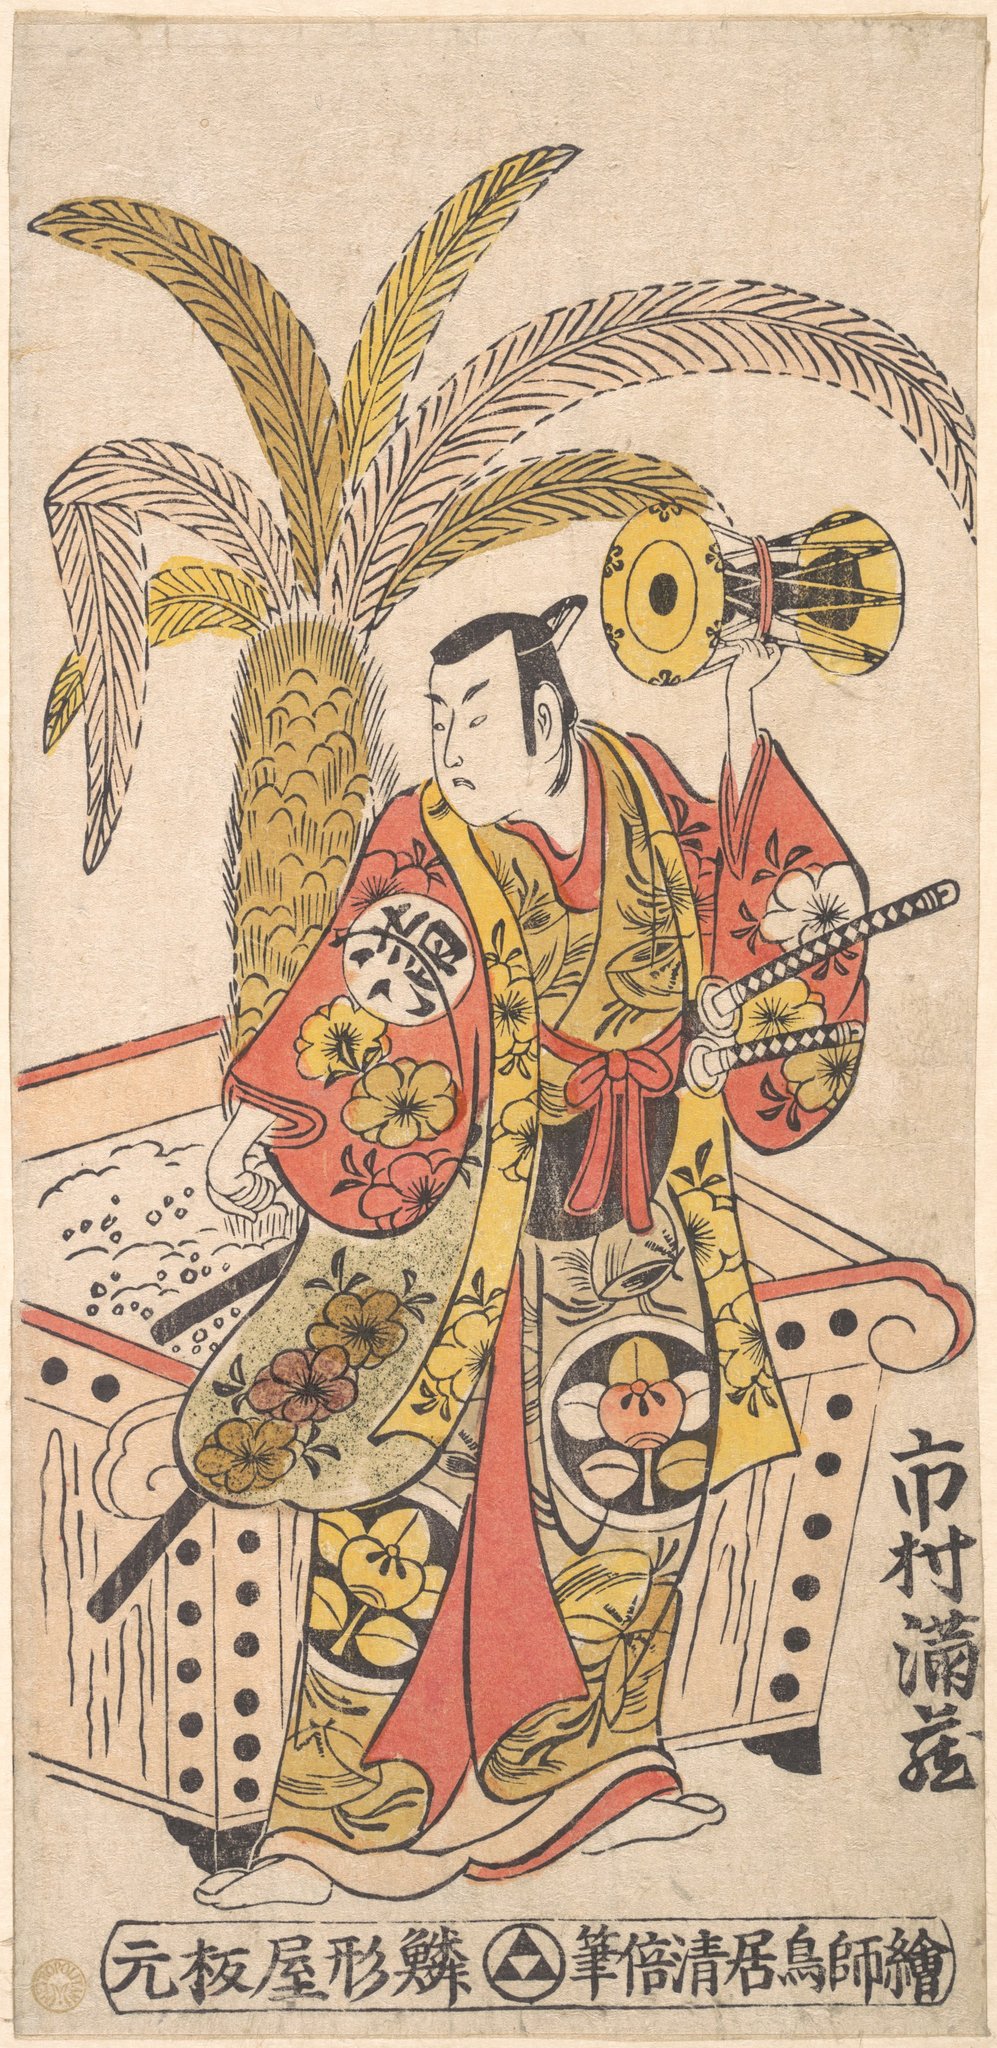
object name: print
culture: japanese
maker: torii kiyomasu i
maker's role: artist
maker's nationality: japanese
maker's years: 1696-1716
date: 1730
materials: ink, paper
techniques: woodblock print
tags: samurai,swords,men,drums,actors